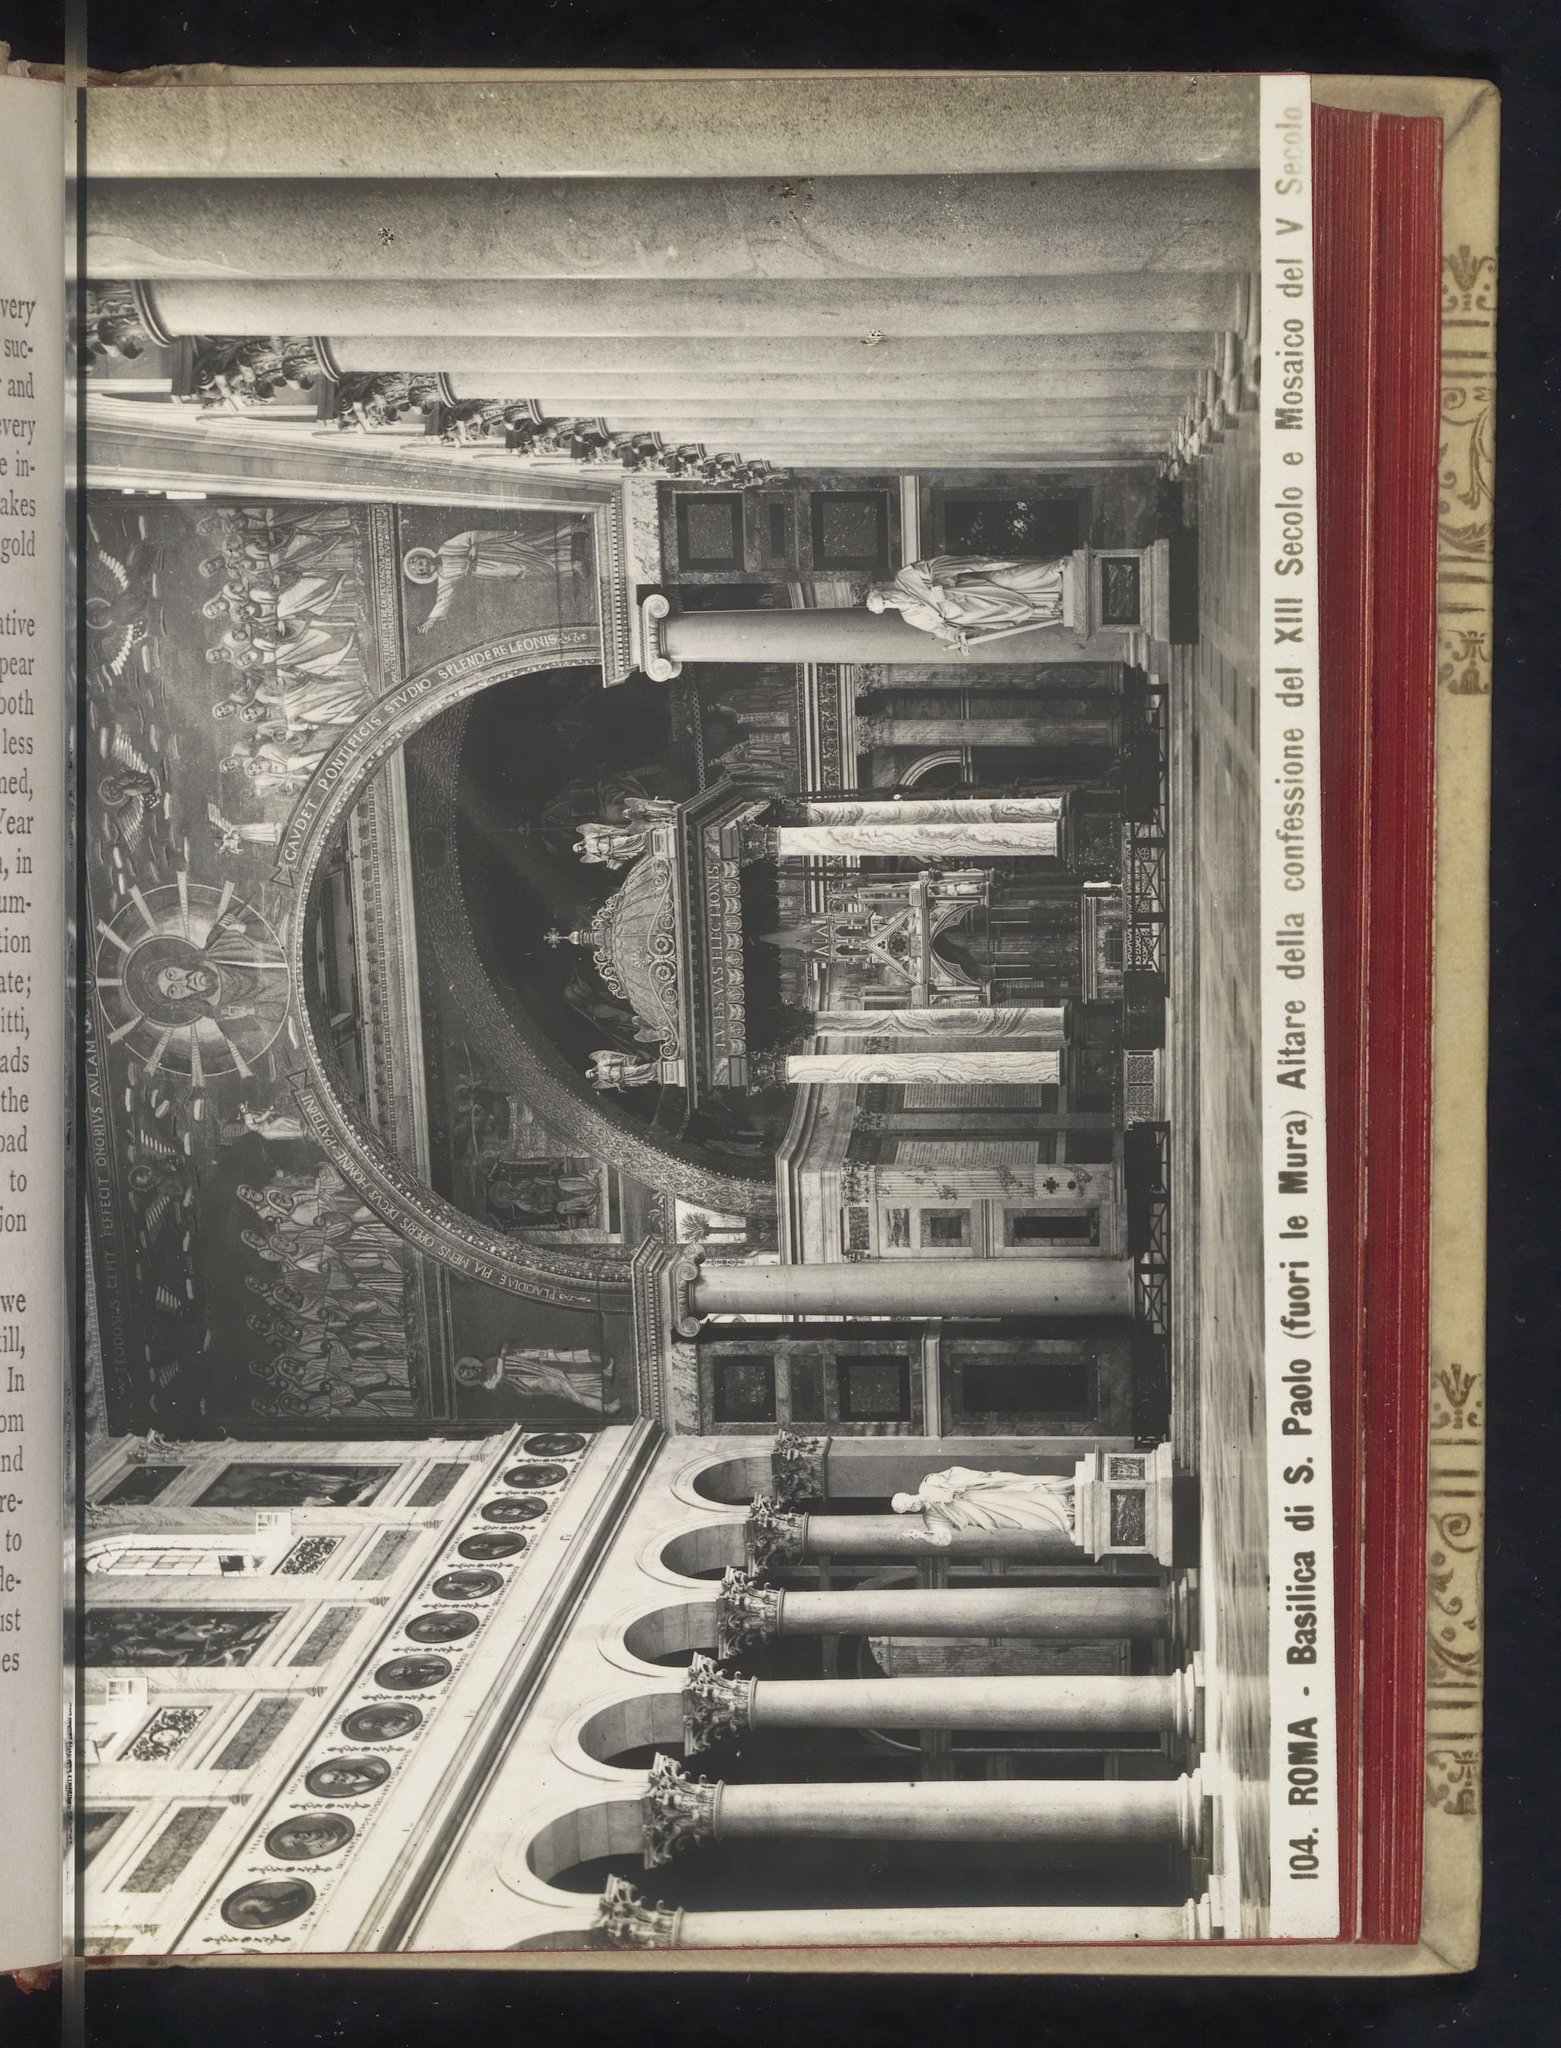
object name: photograph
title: Roma - Basilica di S. Paolo (fuori le Mura) Altaremdella confessione del XIII secolo e mosaico del V secolo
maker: Anonymous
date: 1895-1915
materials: photographic support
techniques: gelatin silver print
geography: sint-paulus buiten de muren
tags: interior of church, parts of church interior: choir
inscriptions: number: ‘104.’